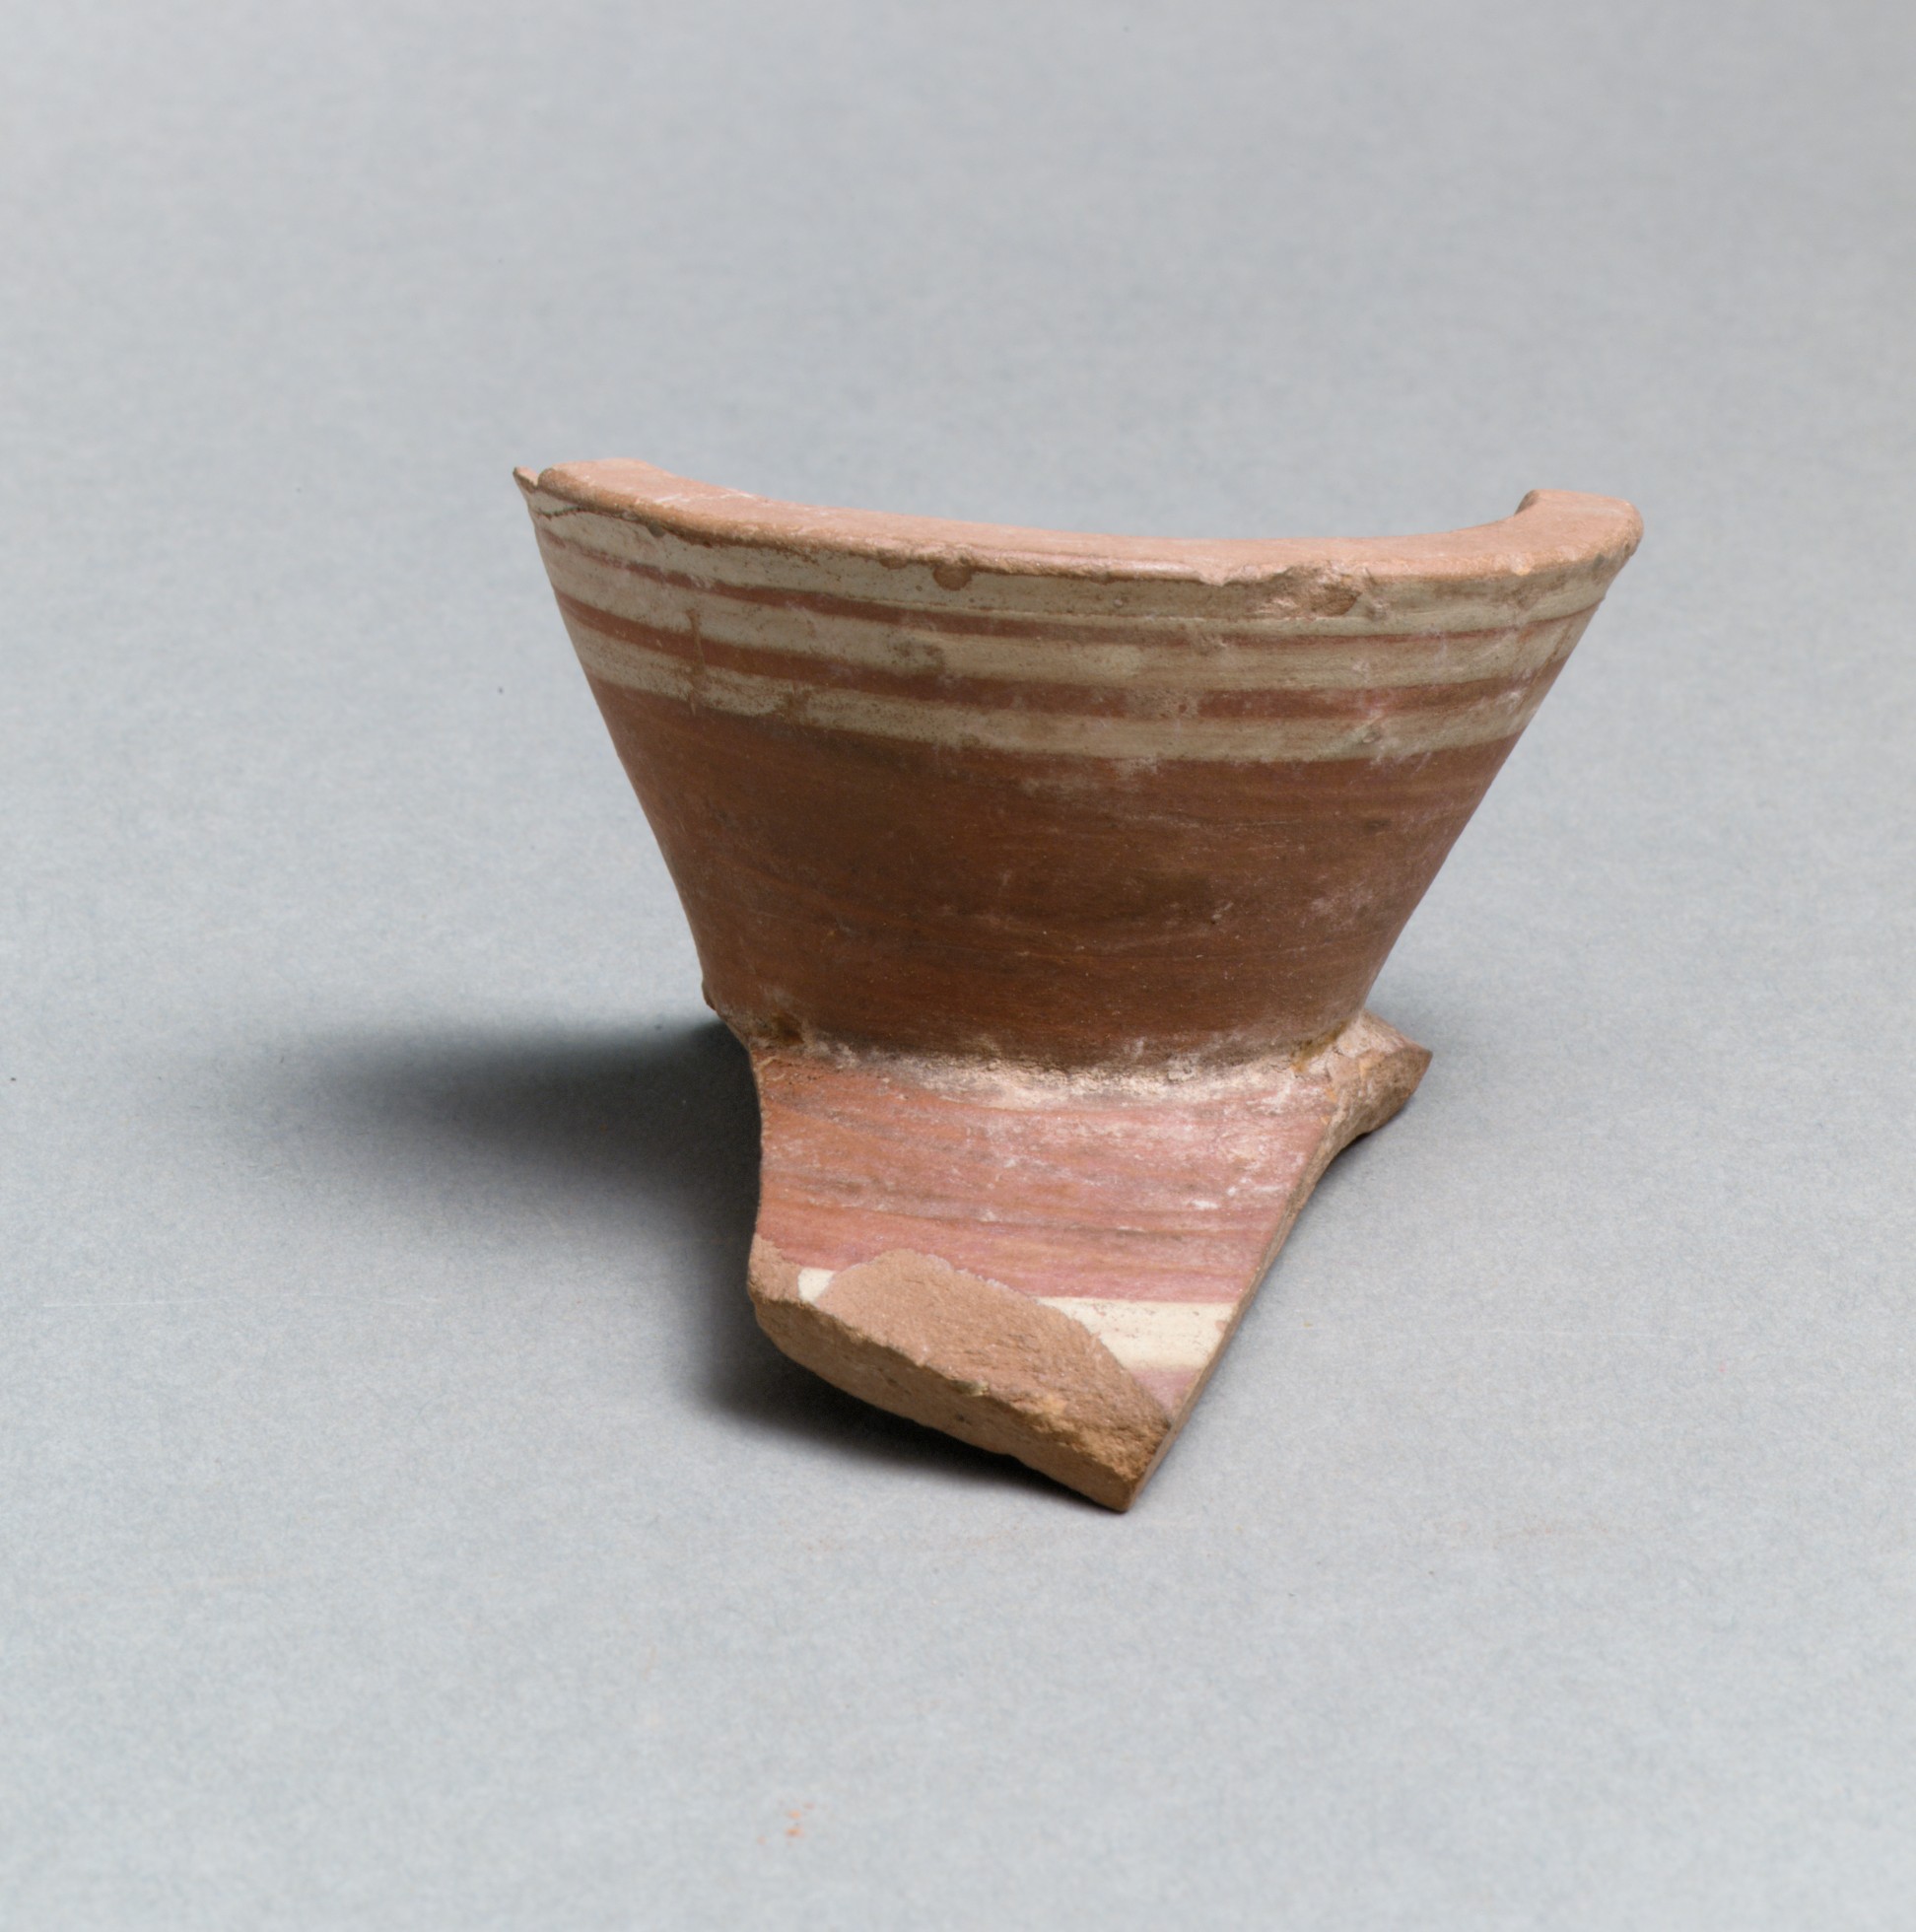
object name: vase fragment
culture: greek or lydian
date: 900-30 BCE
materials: terracotta